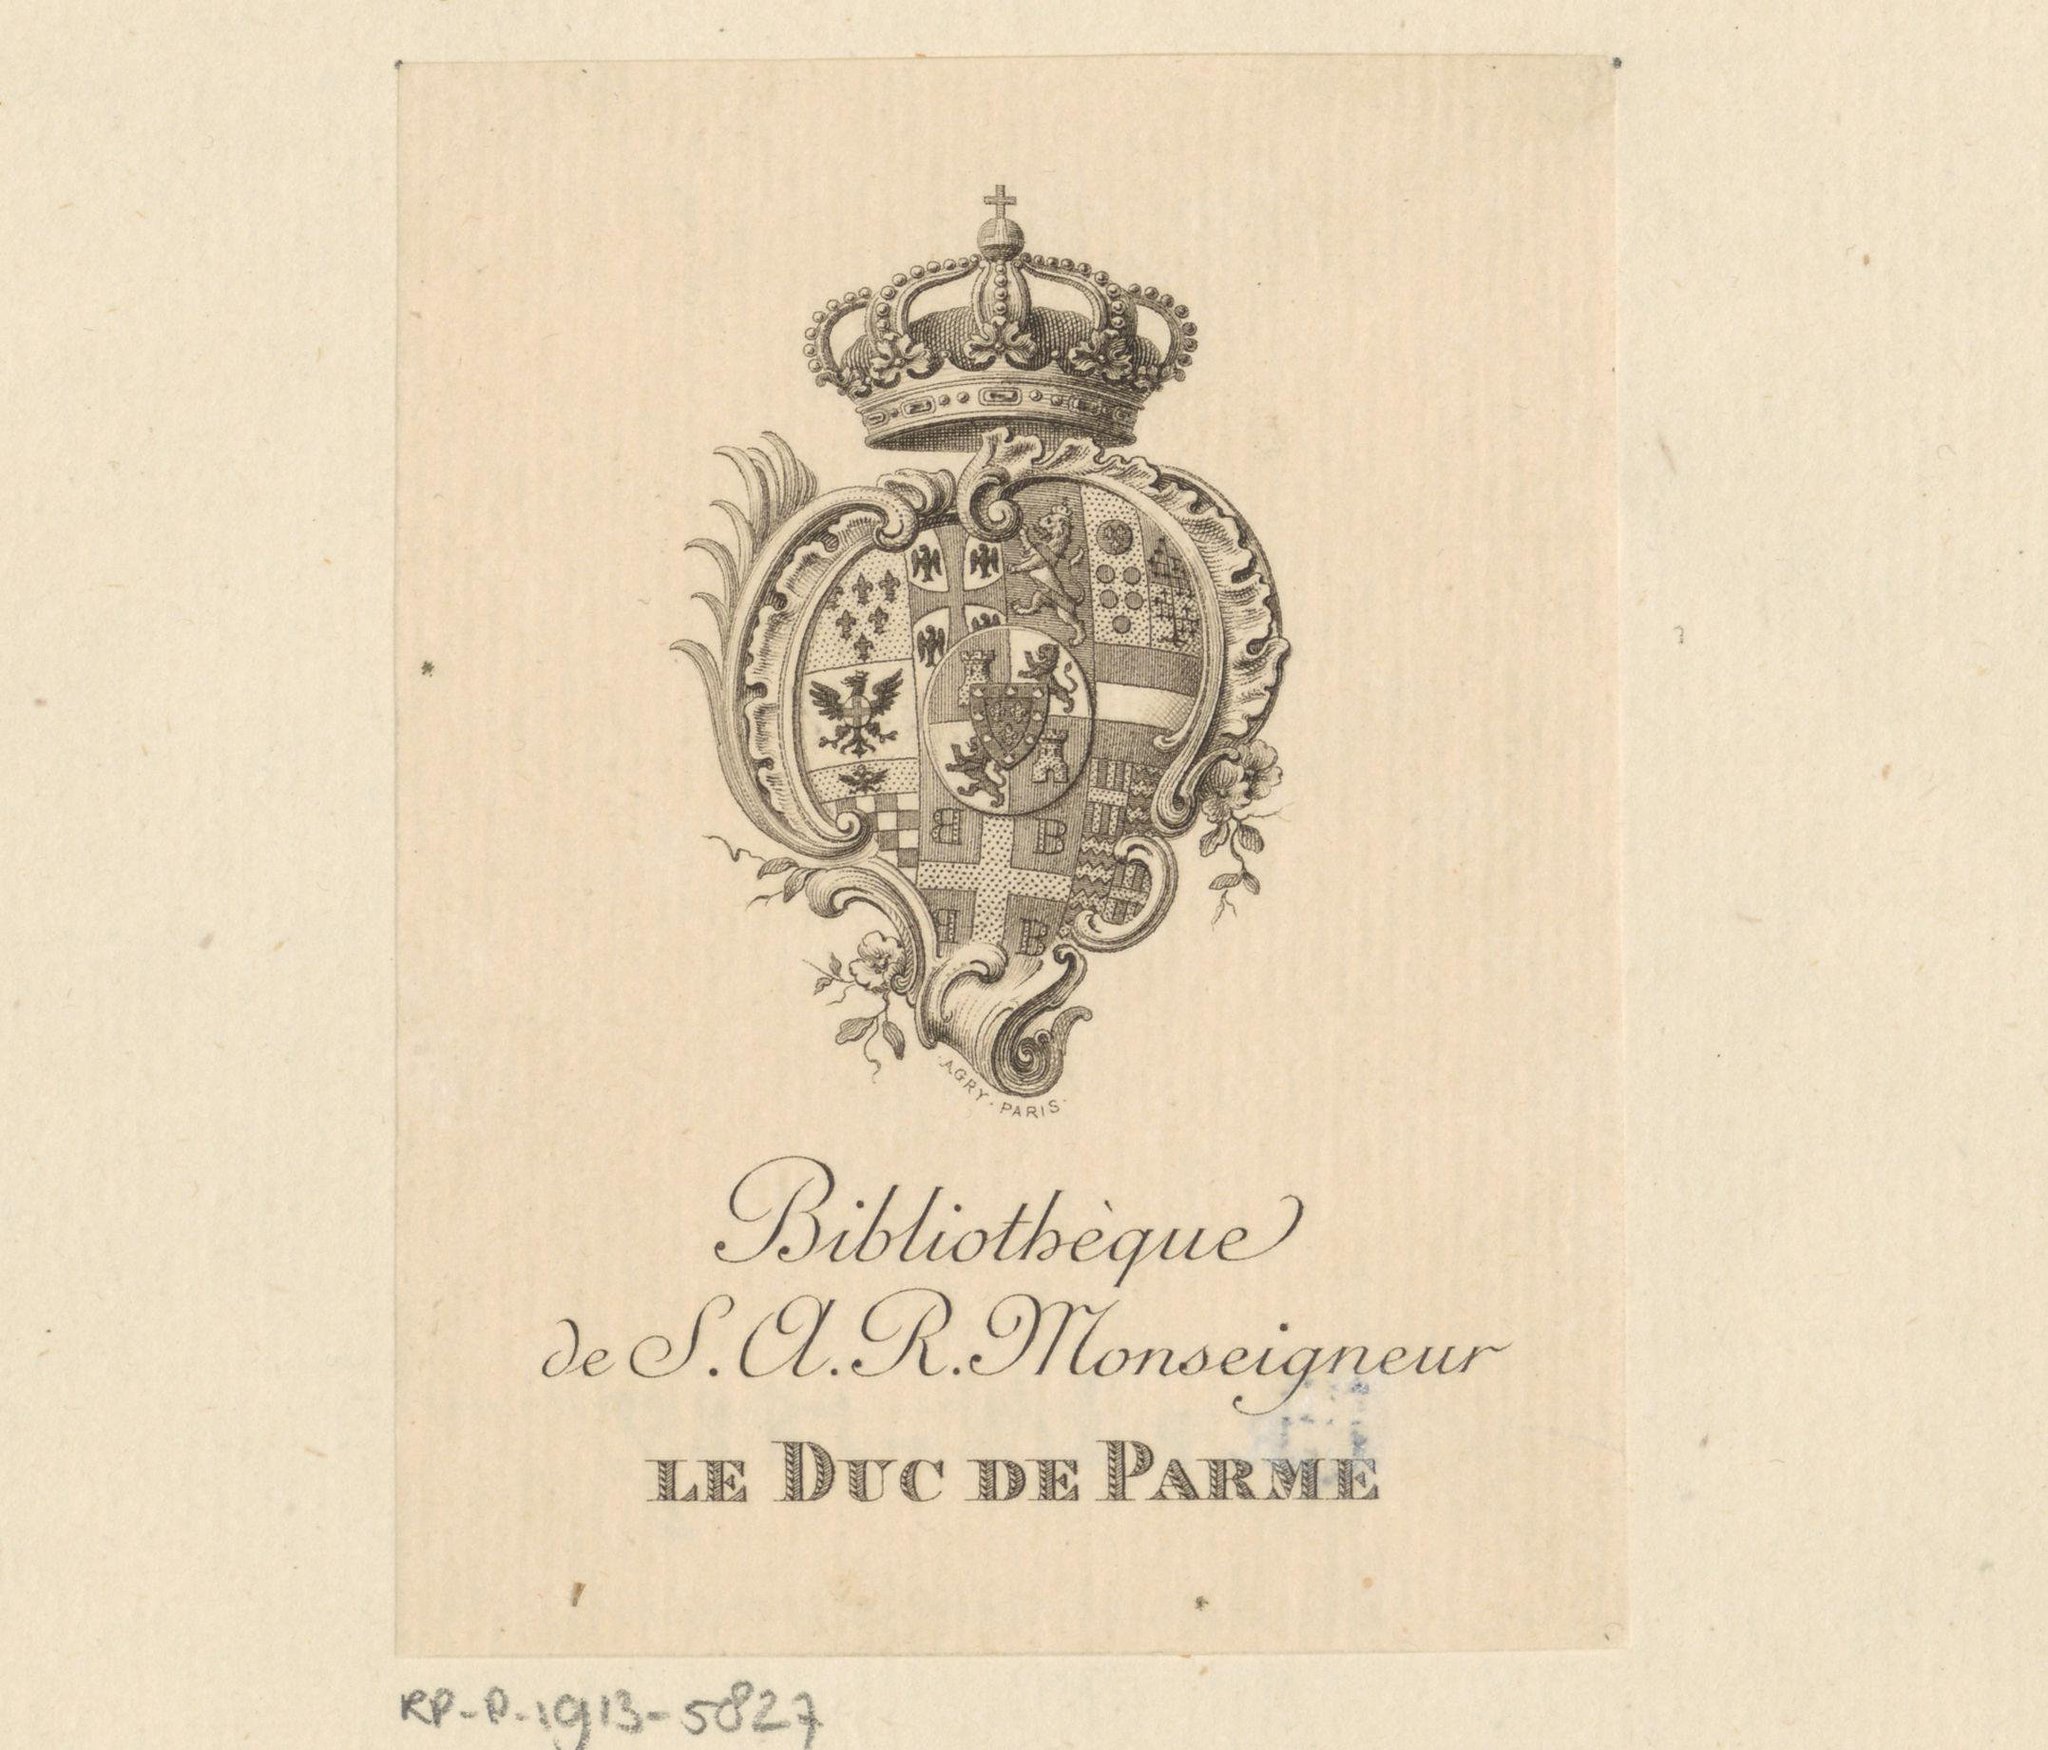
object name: bookplate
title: Ex libris van de graaf van Parma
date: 1870-1880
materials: paper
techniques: engraving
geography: paris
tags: armorial bearing, heraldry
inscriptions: collector's mark: Lugt 2233, collector's mark: Lugt 2760